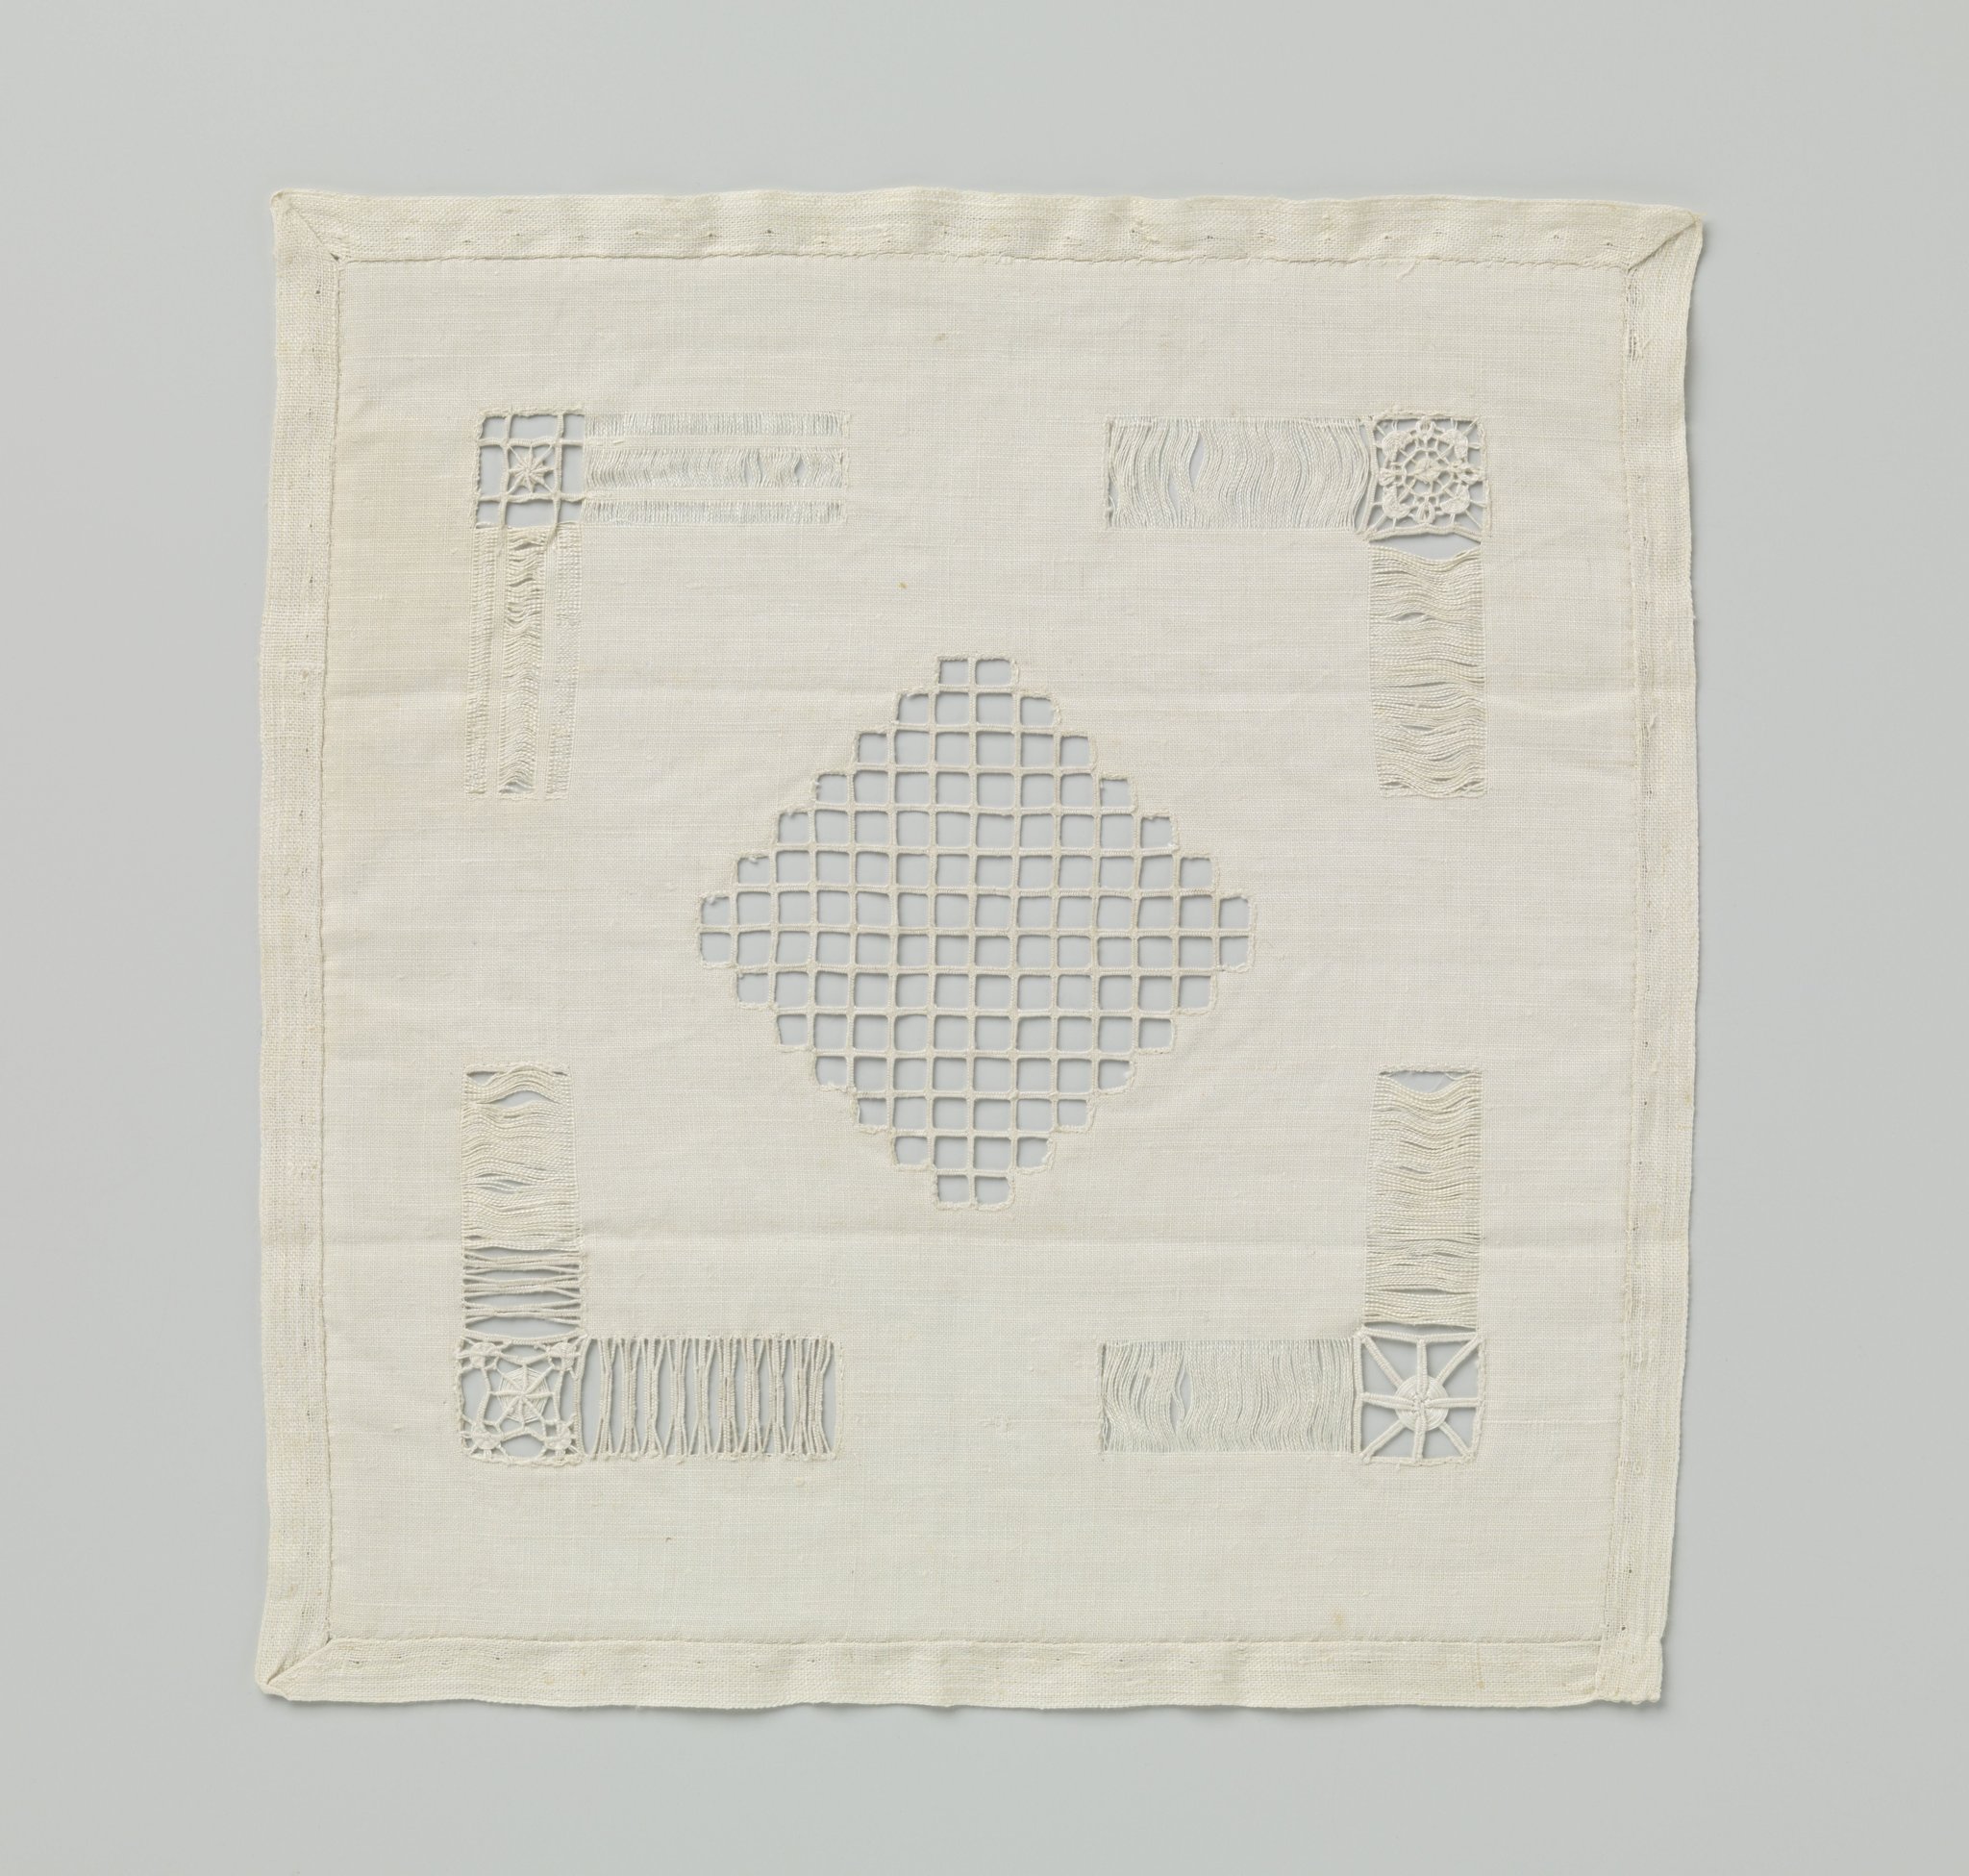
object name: werkstuk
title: Werkstuk voor Diploma fraaie handwerken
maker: geesje smid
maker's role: artisan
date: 1890-1900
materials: linen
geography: netherlands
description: Vierkant stuk linnen met verschillende fasen van point coupé techniek.